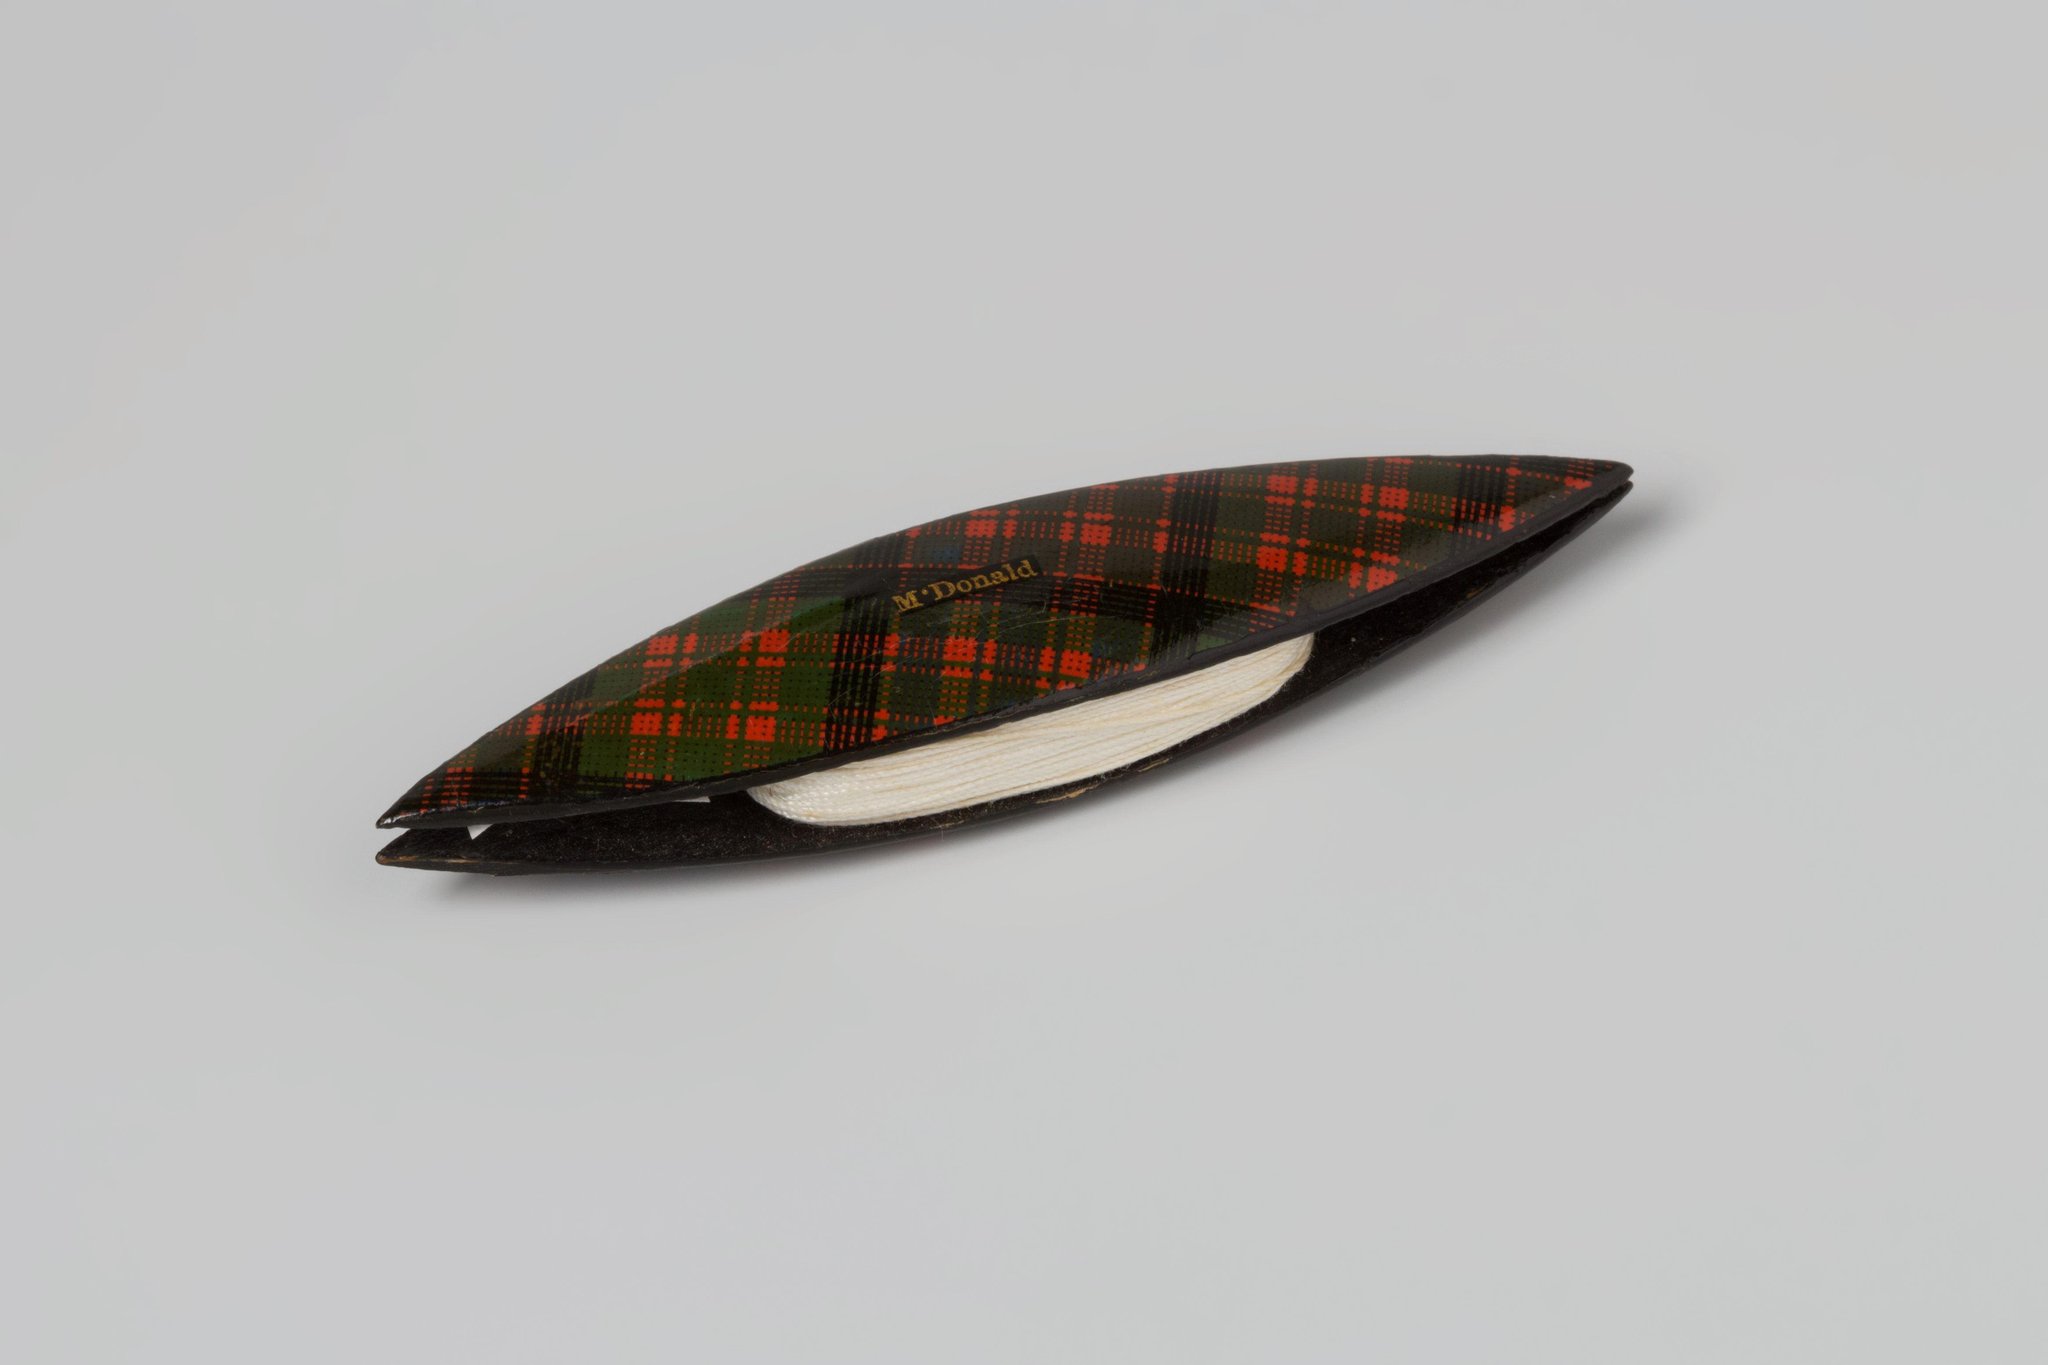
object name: sewing tool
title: Schuitje van hout, beplakt met Schotse ruit, met wit garen gevuld Tartanware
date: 1900-1970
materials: lacquer, paper, silk, wood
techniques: cutting, lacquer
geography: scotland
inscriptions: name: ‘'M'Donald'’, inscription: ‘'Edw. H. and Eva R. Pinto' en 'Trunbridge and Scottisch souvenir woodware, London 1970'’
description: Een schuitje voor frivolité-werk. Van tartan-ware; de Schotse ruit in groen en rood is in goud bedrukt met 'M'Donald', met wit garen gevuld.